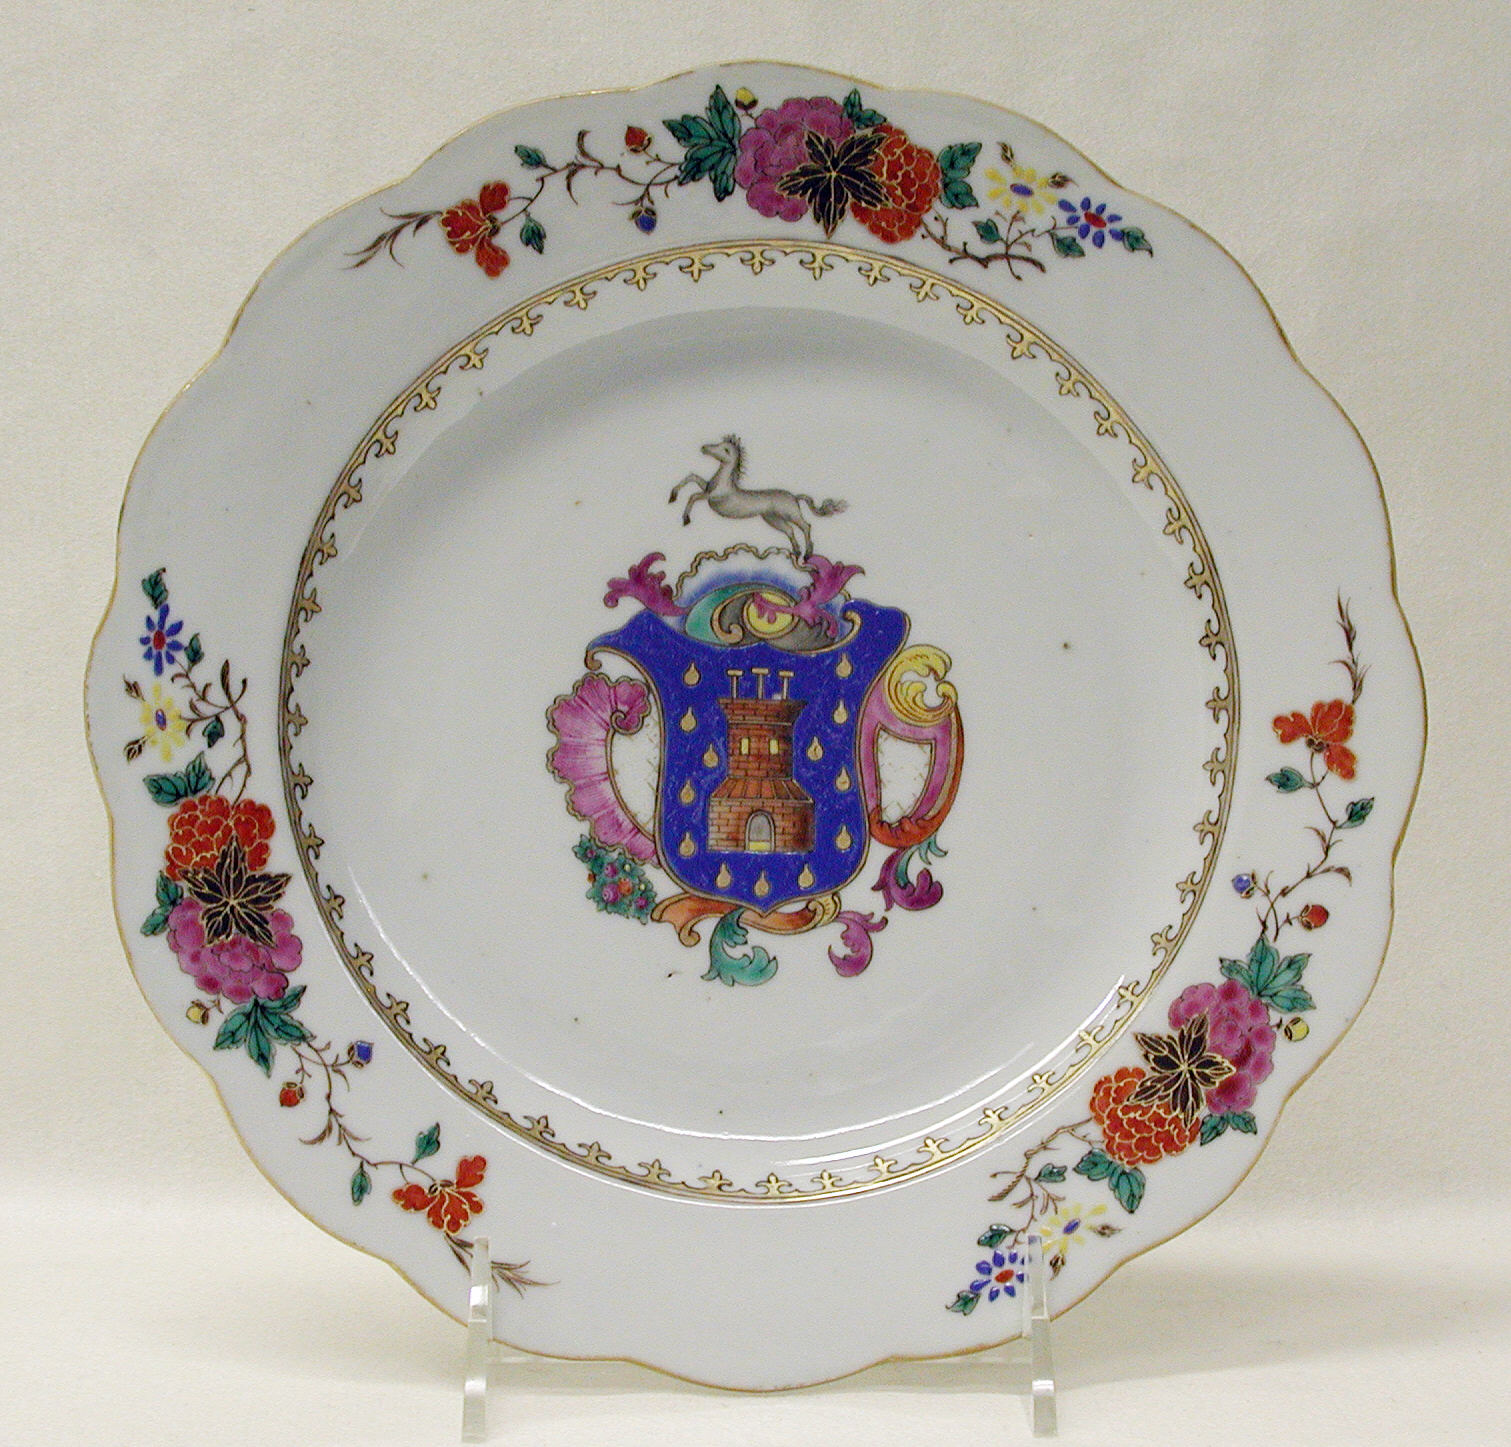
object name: plate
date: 1765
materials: hard paste porcelain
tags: horses,flowers,coat of arms